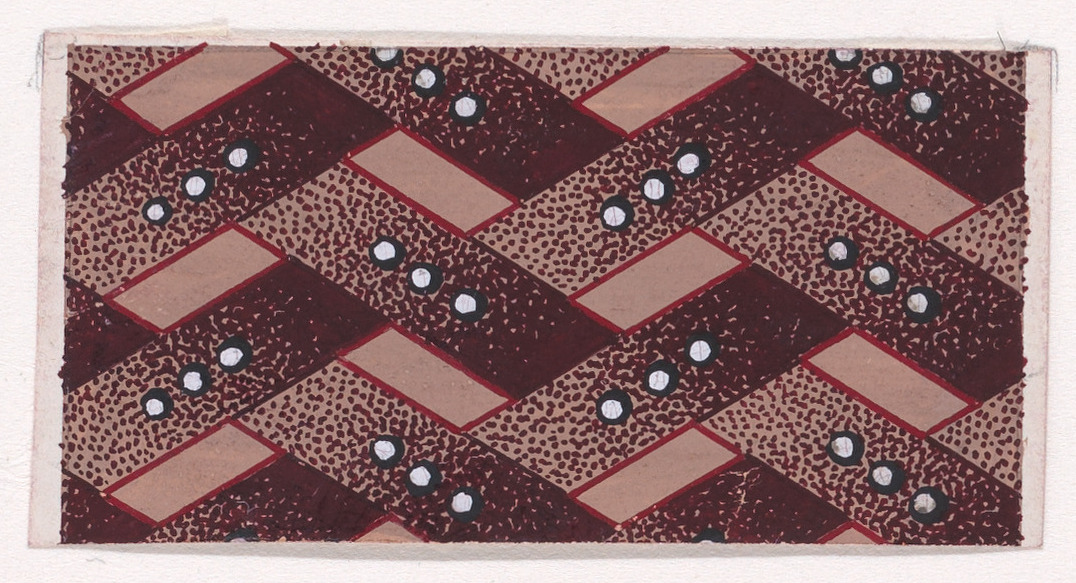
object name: drawing ornament architecture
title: Textile Design with a Basketweave Pattern and Pearls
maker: anonymous, alsatian, 19th century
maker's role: artist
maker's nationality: alsatian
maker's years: 1800-1900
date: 1840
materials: gouache